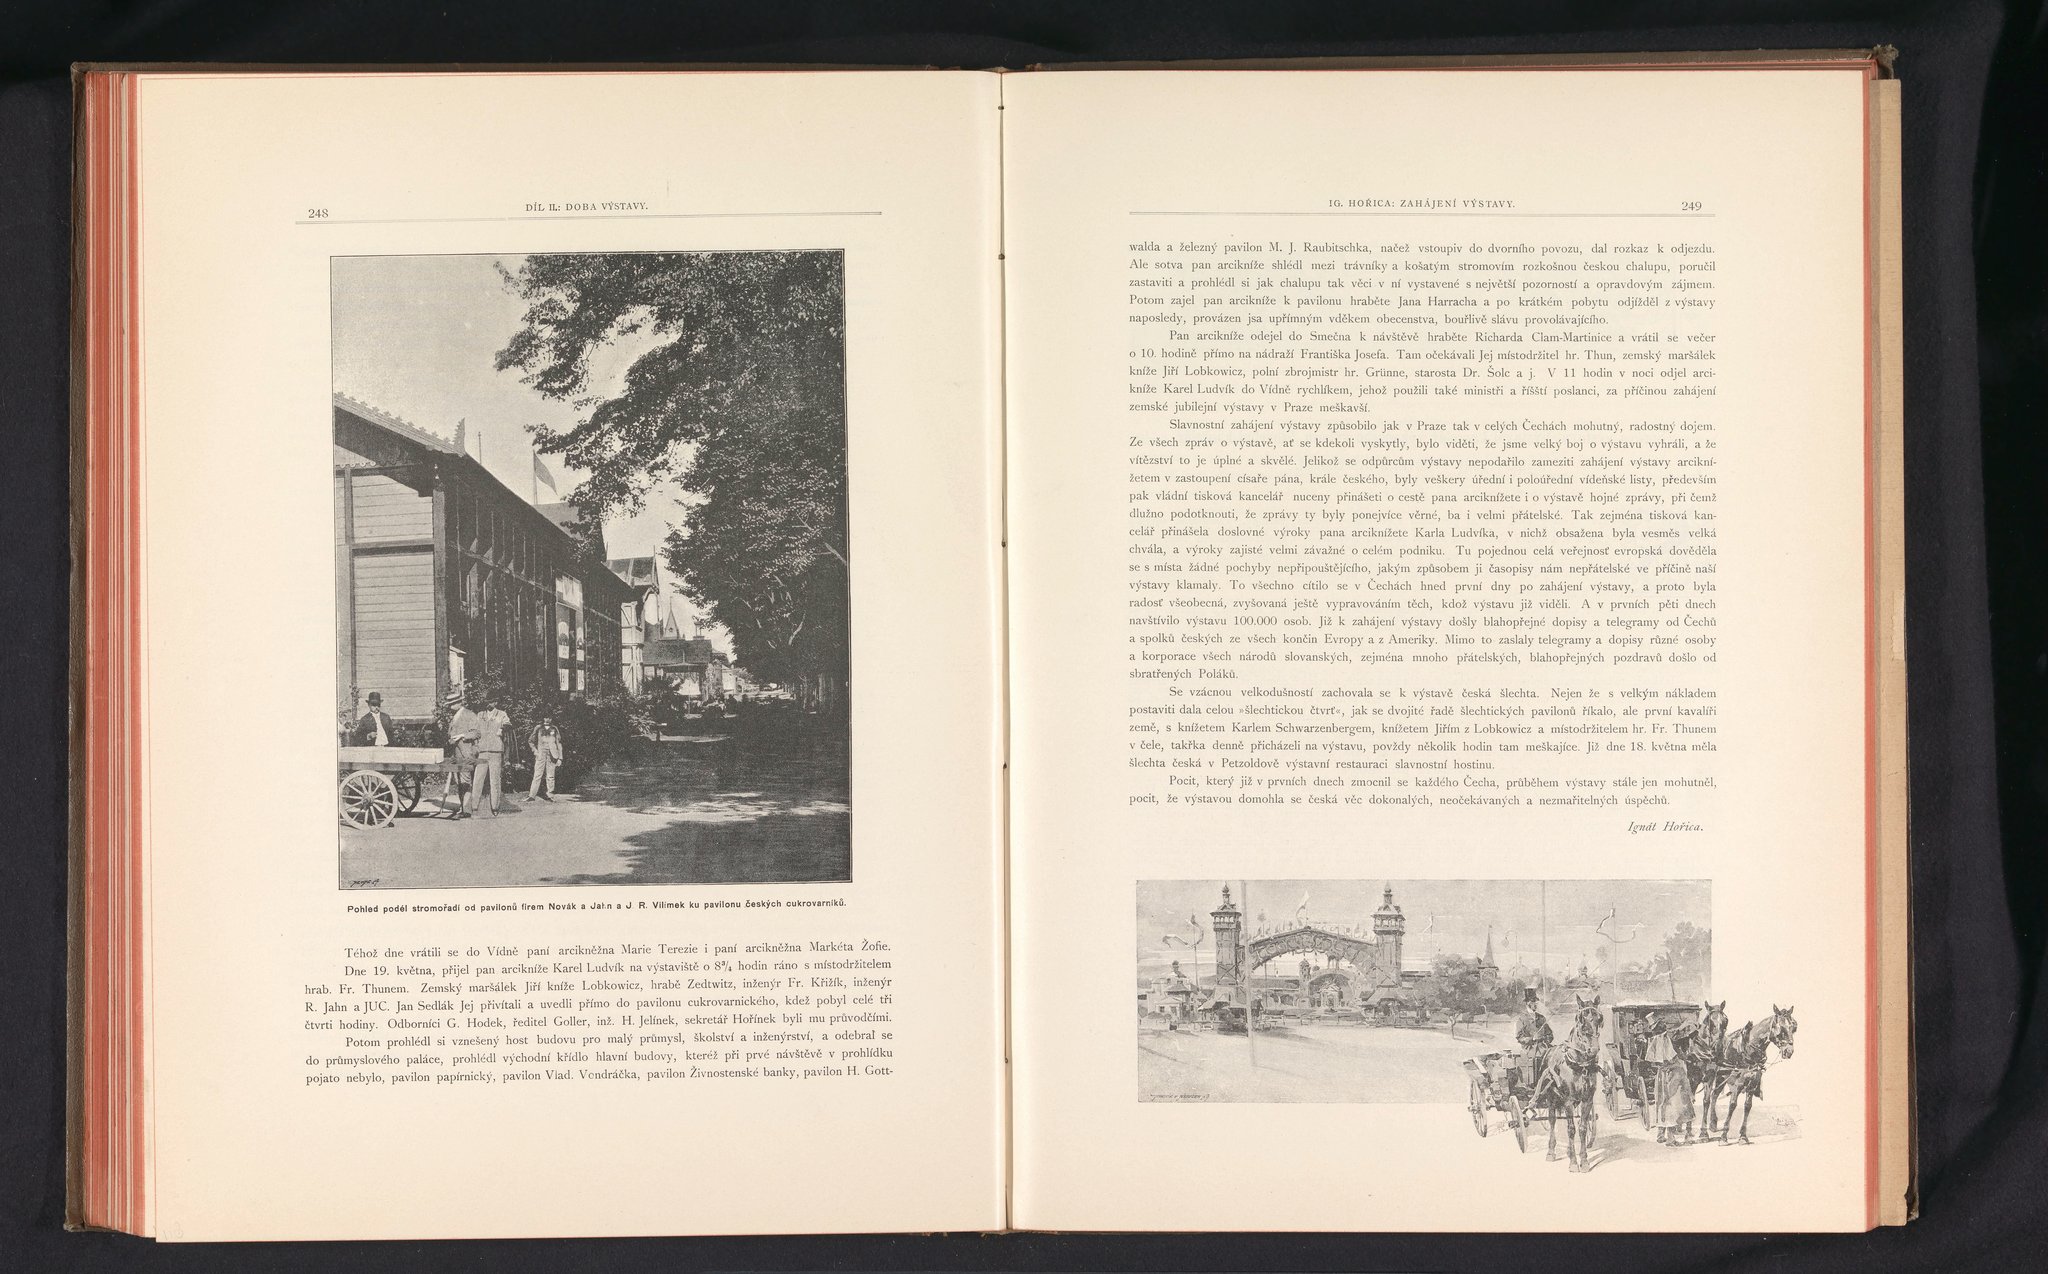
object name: photomechanical print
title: Pohled podél stromoradi od pavilonú firem Novák a Jahn a J. R. Vilimek ku pavilonu ceských cukrovarnikú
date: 1891-1893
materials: paper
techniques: autotype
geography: prague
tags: façade (of house or building), temporary exhibition, 'salon'